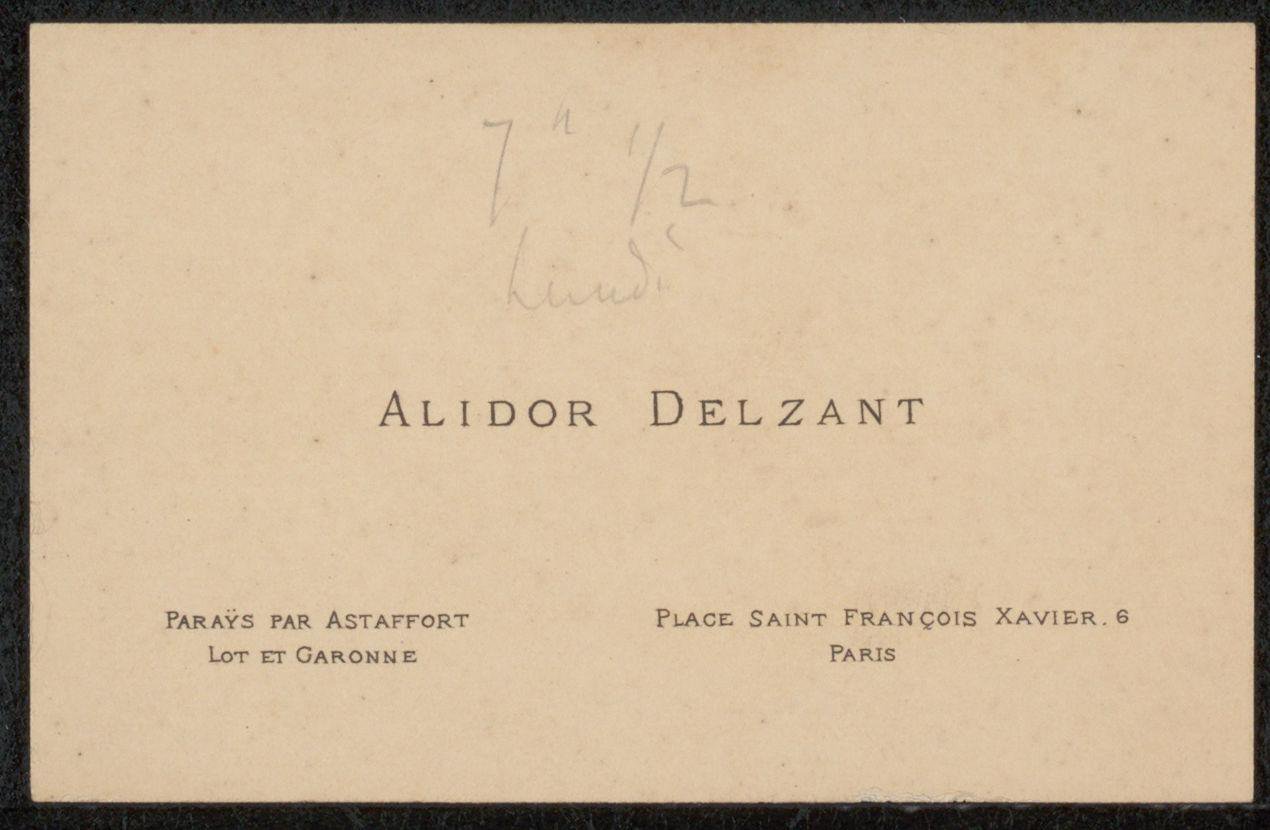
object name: visiting card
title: Visitekaartje aan Philip Zilcken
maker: alidor delzant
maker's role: advocaat, auteur, kunstverzamelaar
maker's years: 1848-1905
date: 1858-1905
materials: cardboard, ink, pencil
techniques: pen, printing, writing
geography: paris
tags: the hague, painter, draughtsman, philip zilcken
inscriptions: collector's mark: ‘RPK’